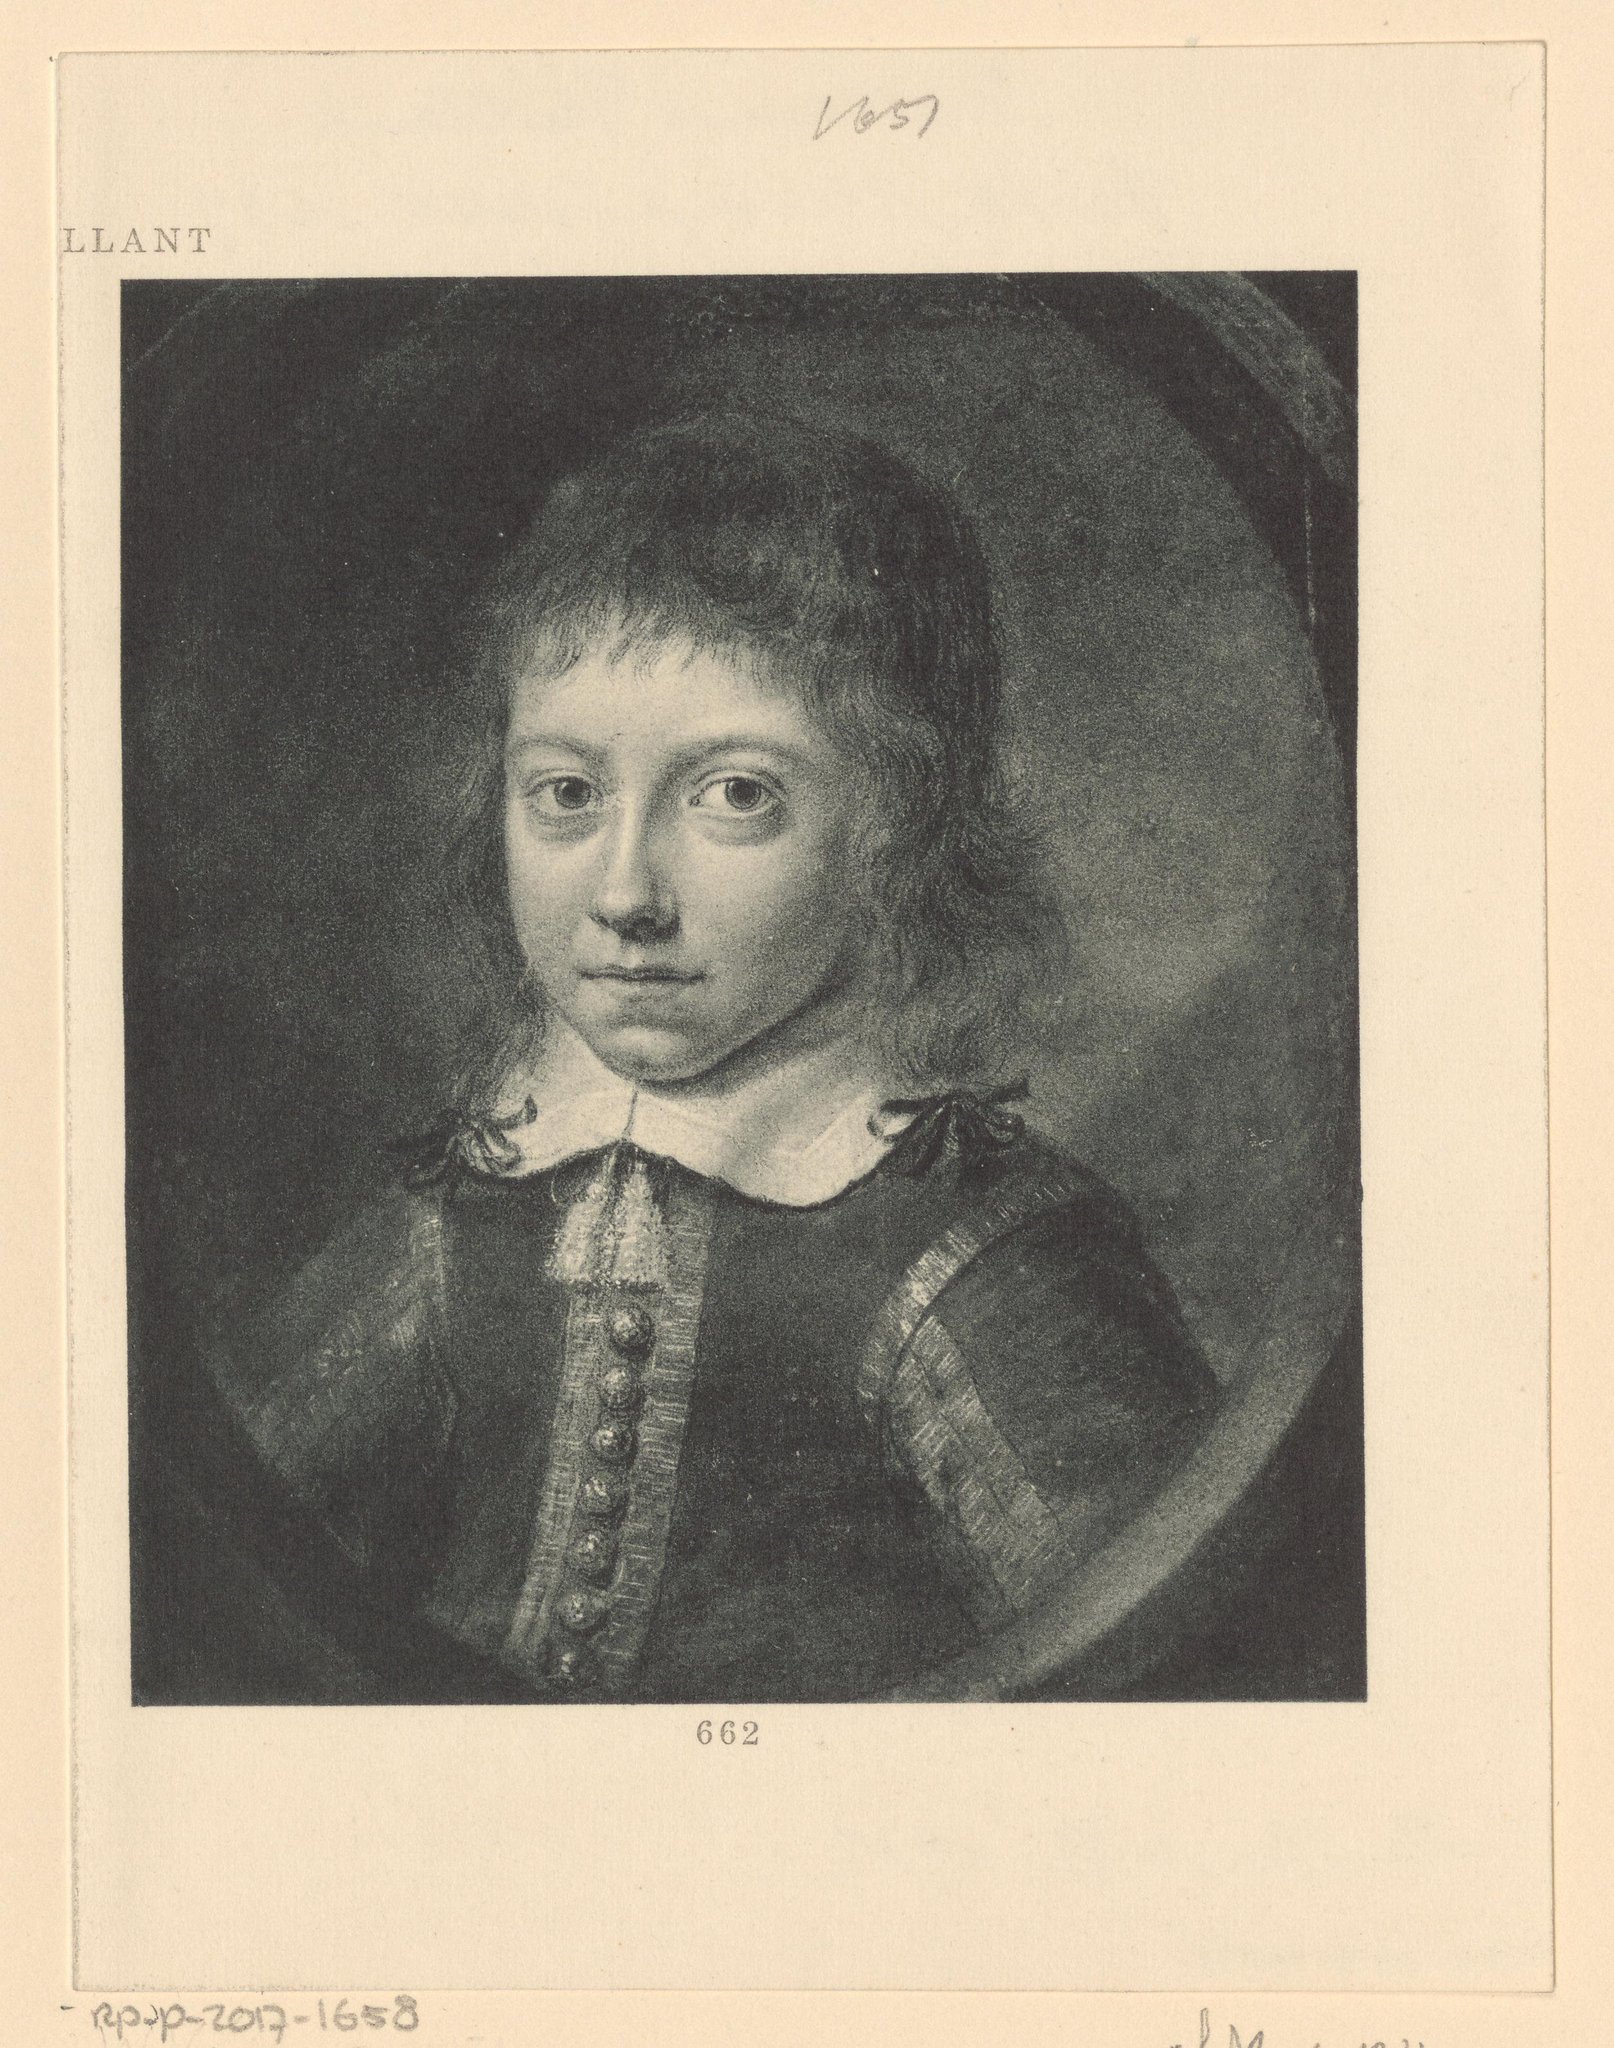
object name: photomechanical print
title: Portret van Dirck Alewijn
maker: Anonymous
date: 1850-1949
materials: paper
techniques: photograph, letterpress printing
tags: dirck alewijn